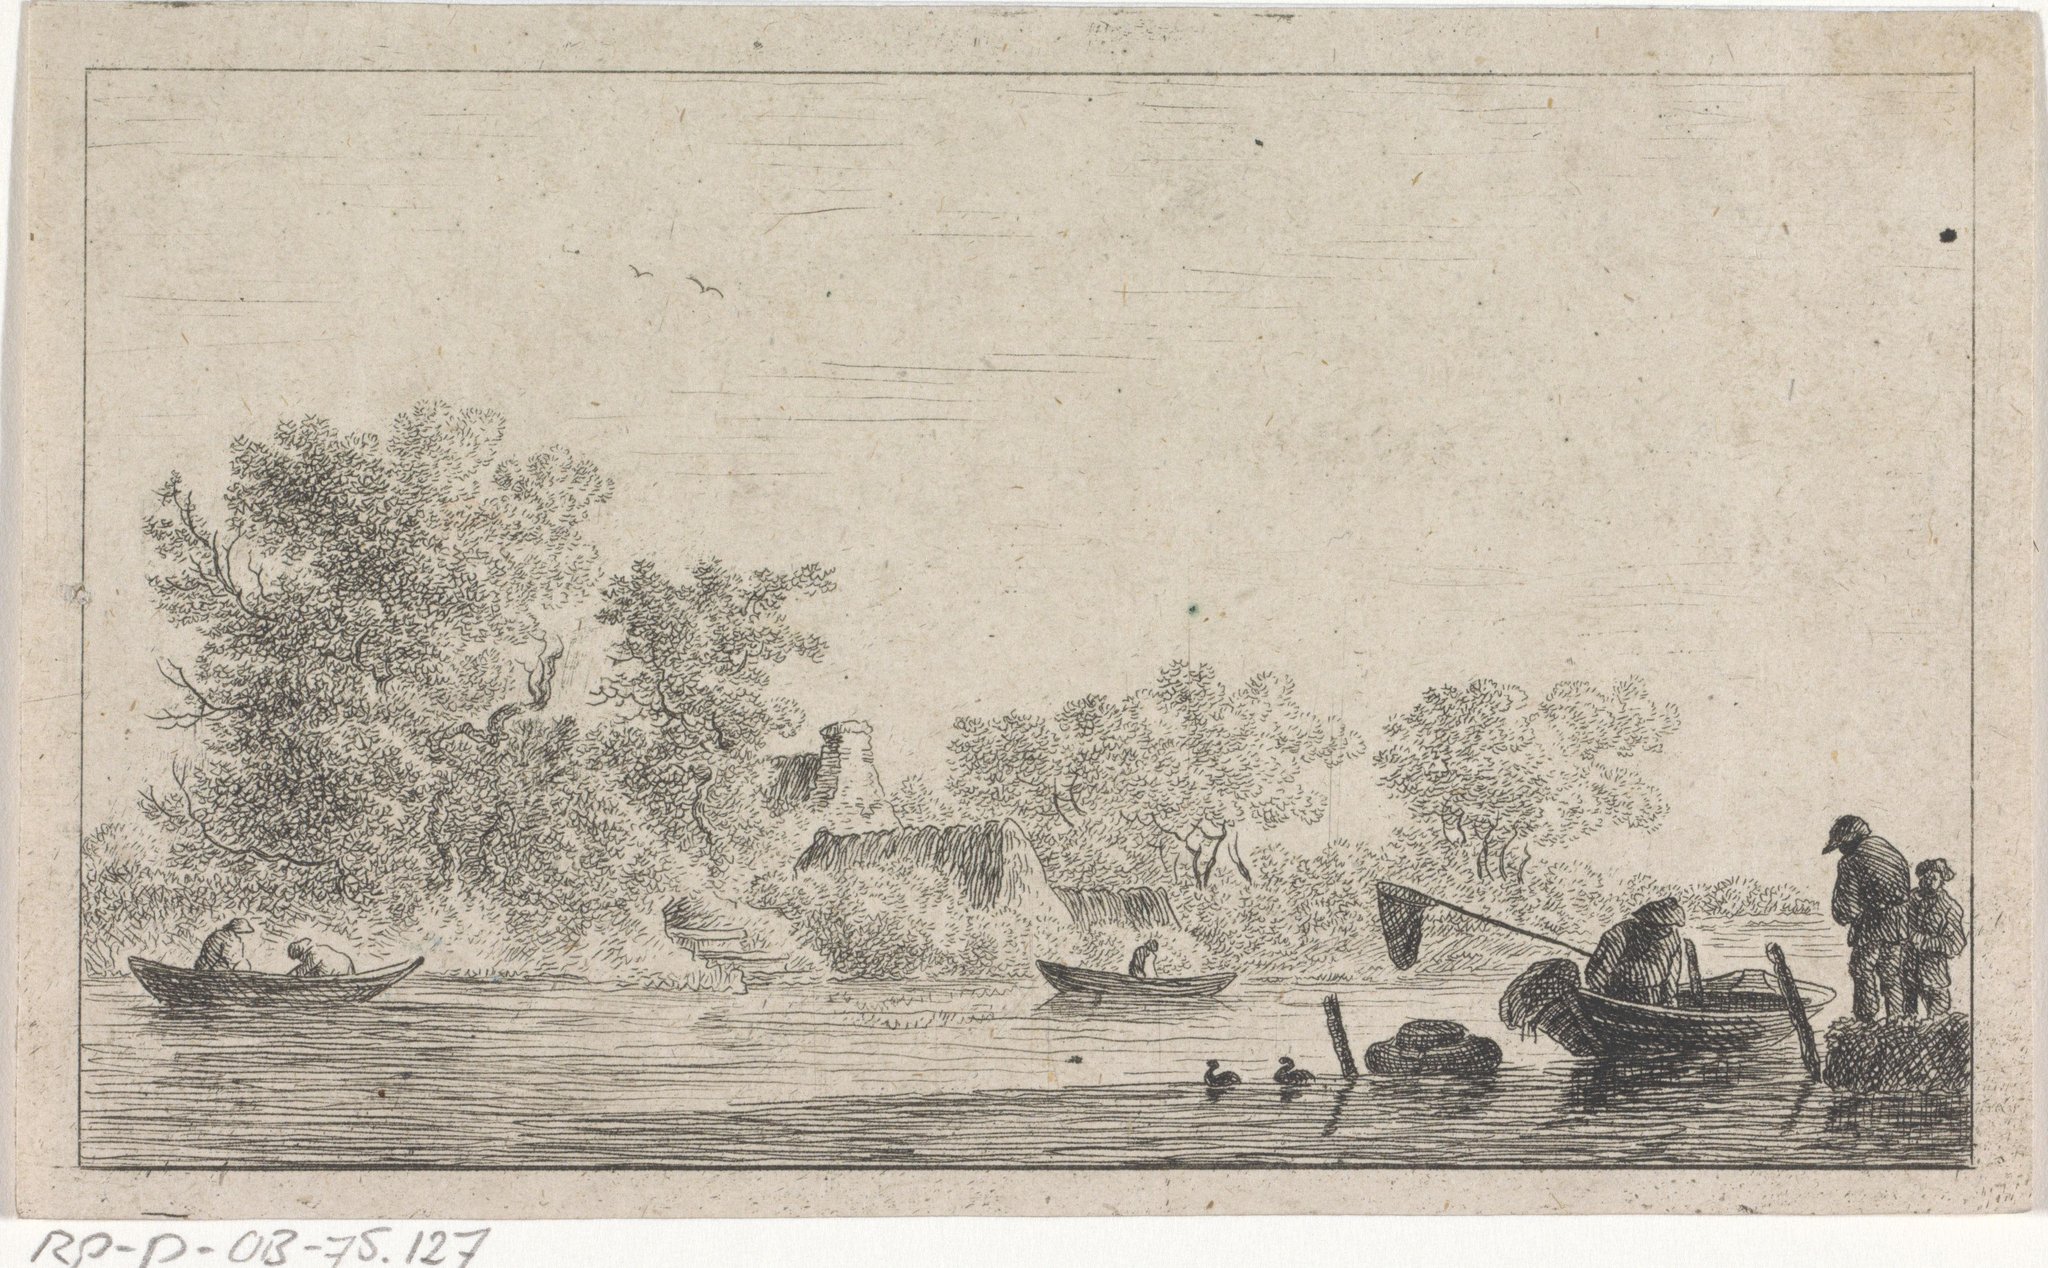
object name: print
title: Rivierlandschap met vissers in bootjes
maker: Anonymous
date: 1650-1750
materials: paper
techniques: etching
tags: river, rowing-boat, canoe, etc.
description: Landschap met een rivier of vaart waarop enkele sloepen met vissers. Rechts een man met schepnet in een boot en twee figuren op de kant. Aan de overzijde van het water bomen en een woning.